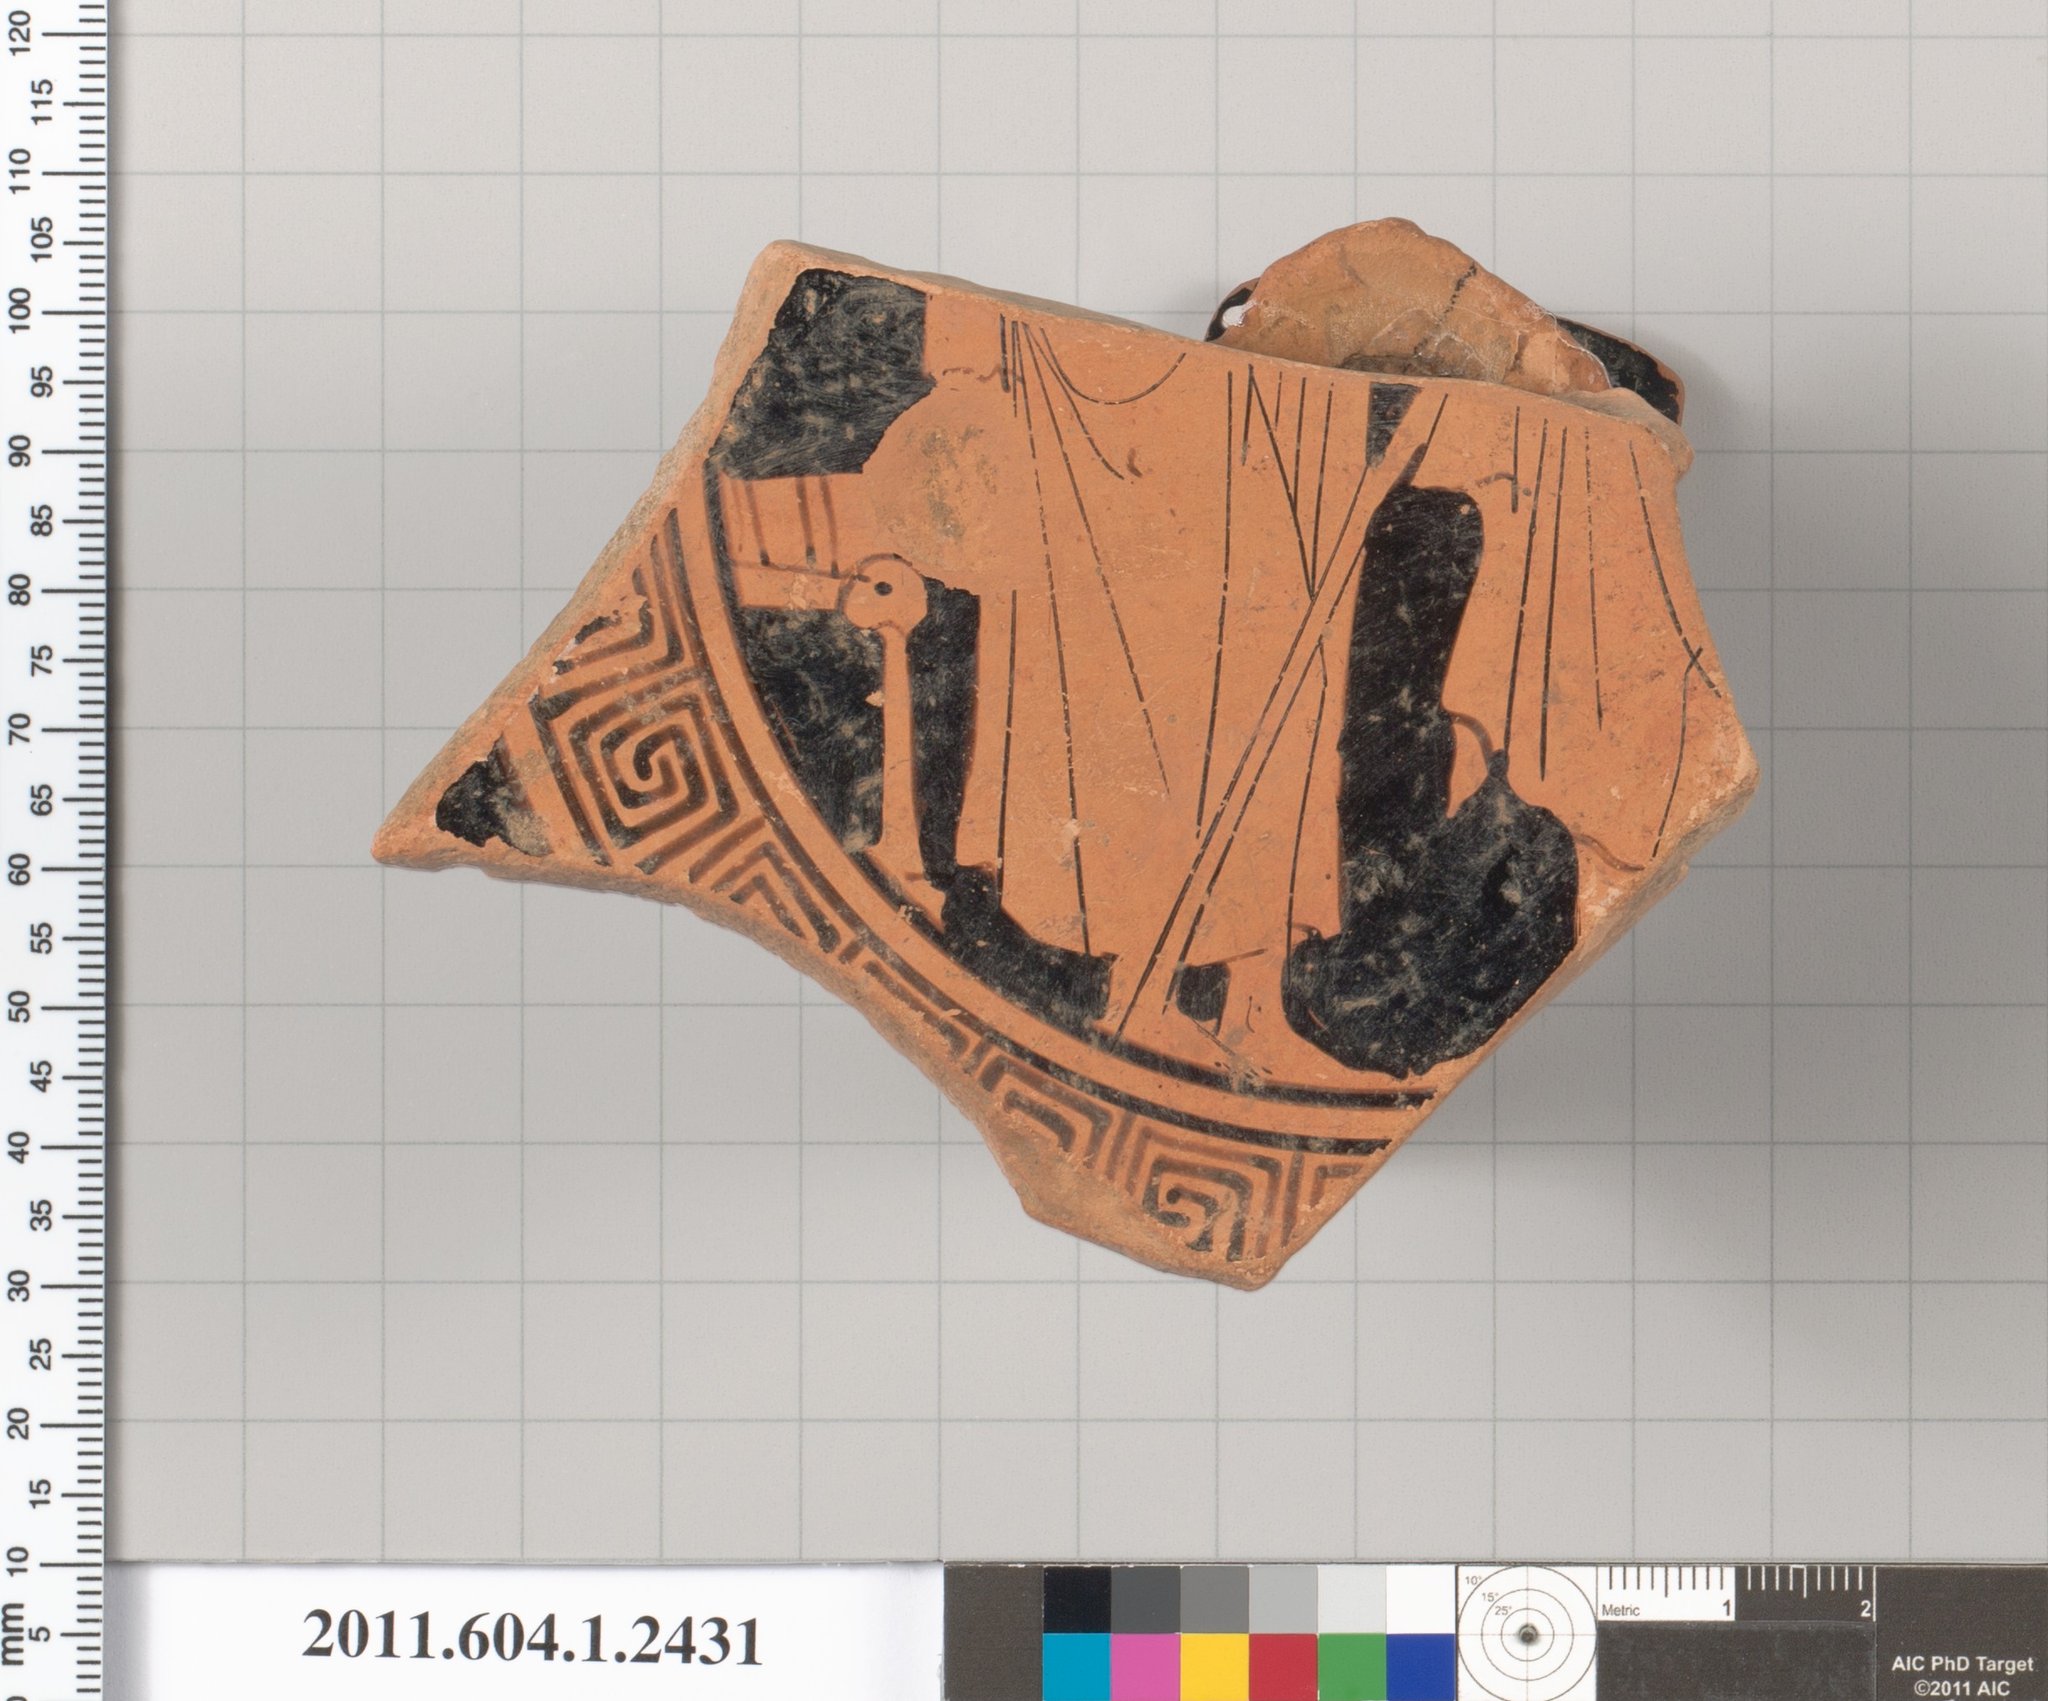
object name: kylix fragment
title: Terracotta fragment of a kylix (drinking cup)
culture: greek, attic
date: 475-451 BCE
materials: terracotta